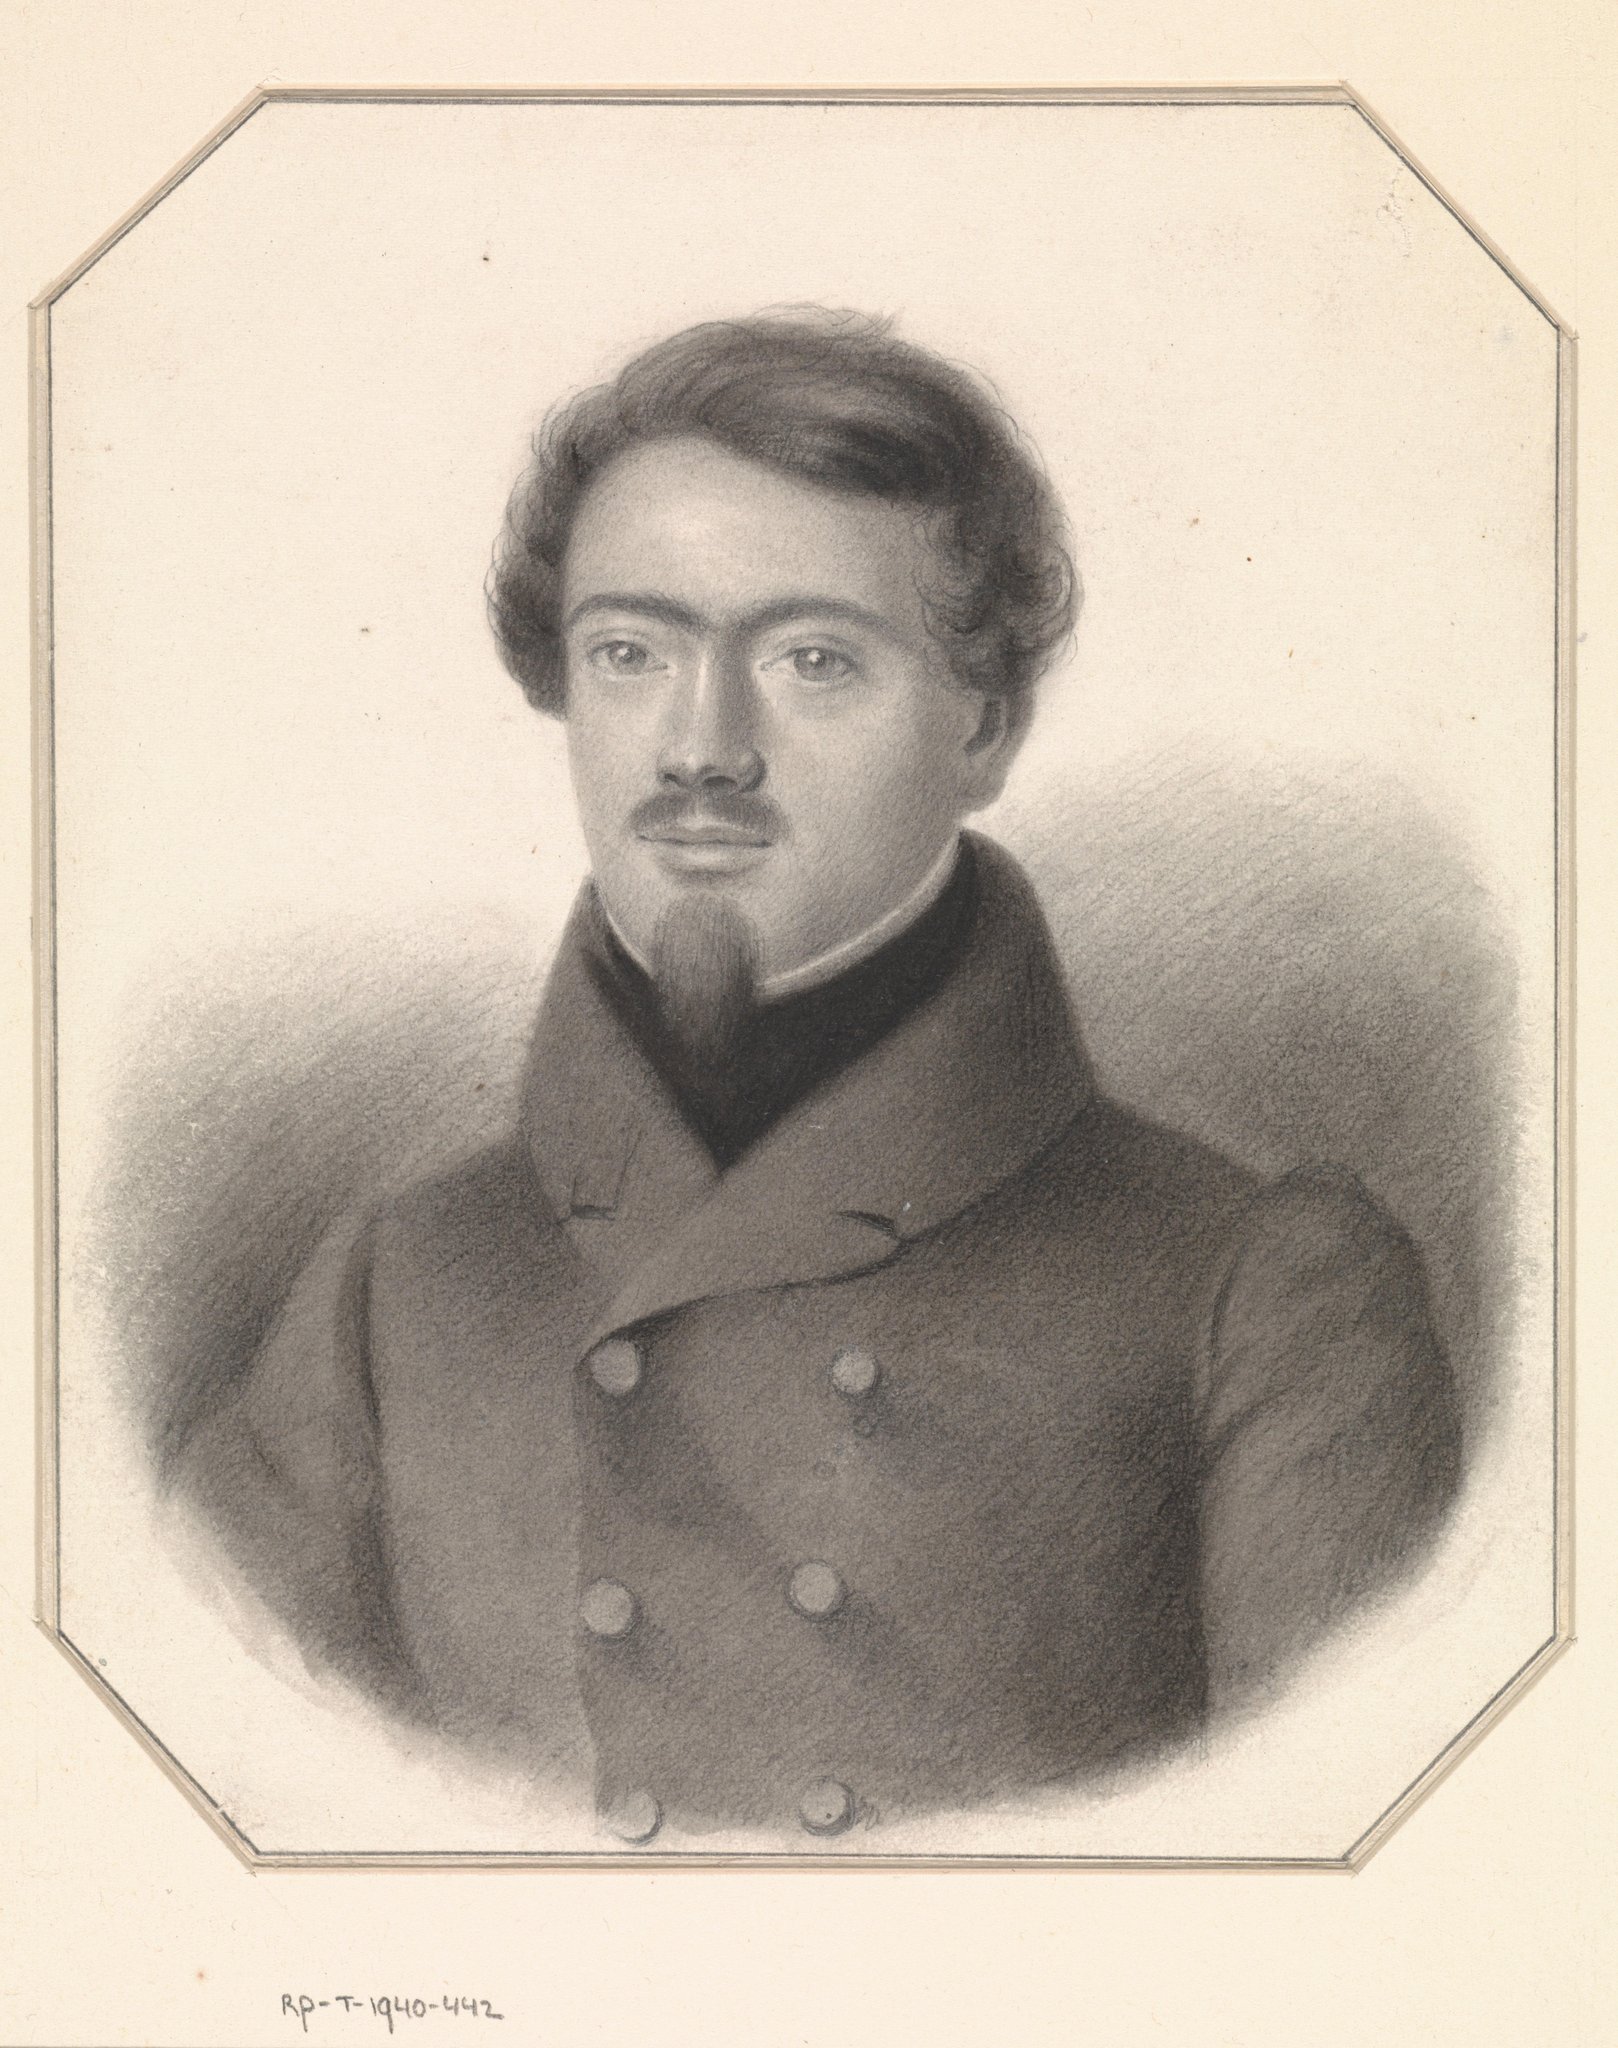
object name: drawing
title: Portret van George Gillis Haanen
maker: Anonymous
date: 1820-1900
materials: chalk, paper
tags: utrecht, painter, print maker, draughtsman, george gillis haanen, historical persons, portrait, self-portrait of painter, portrait, self-portrait of artist, portrait, self-portrait of draughtsman